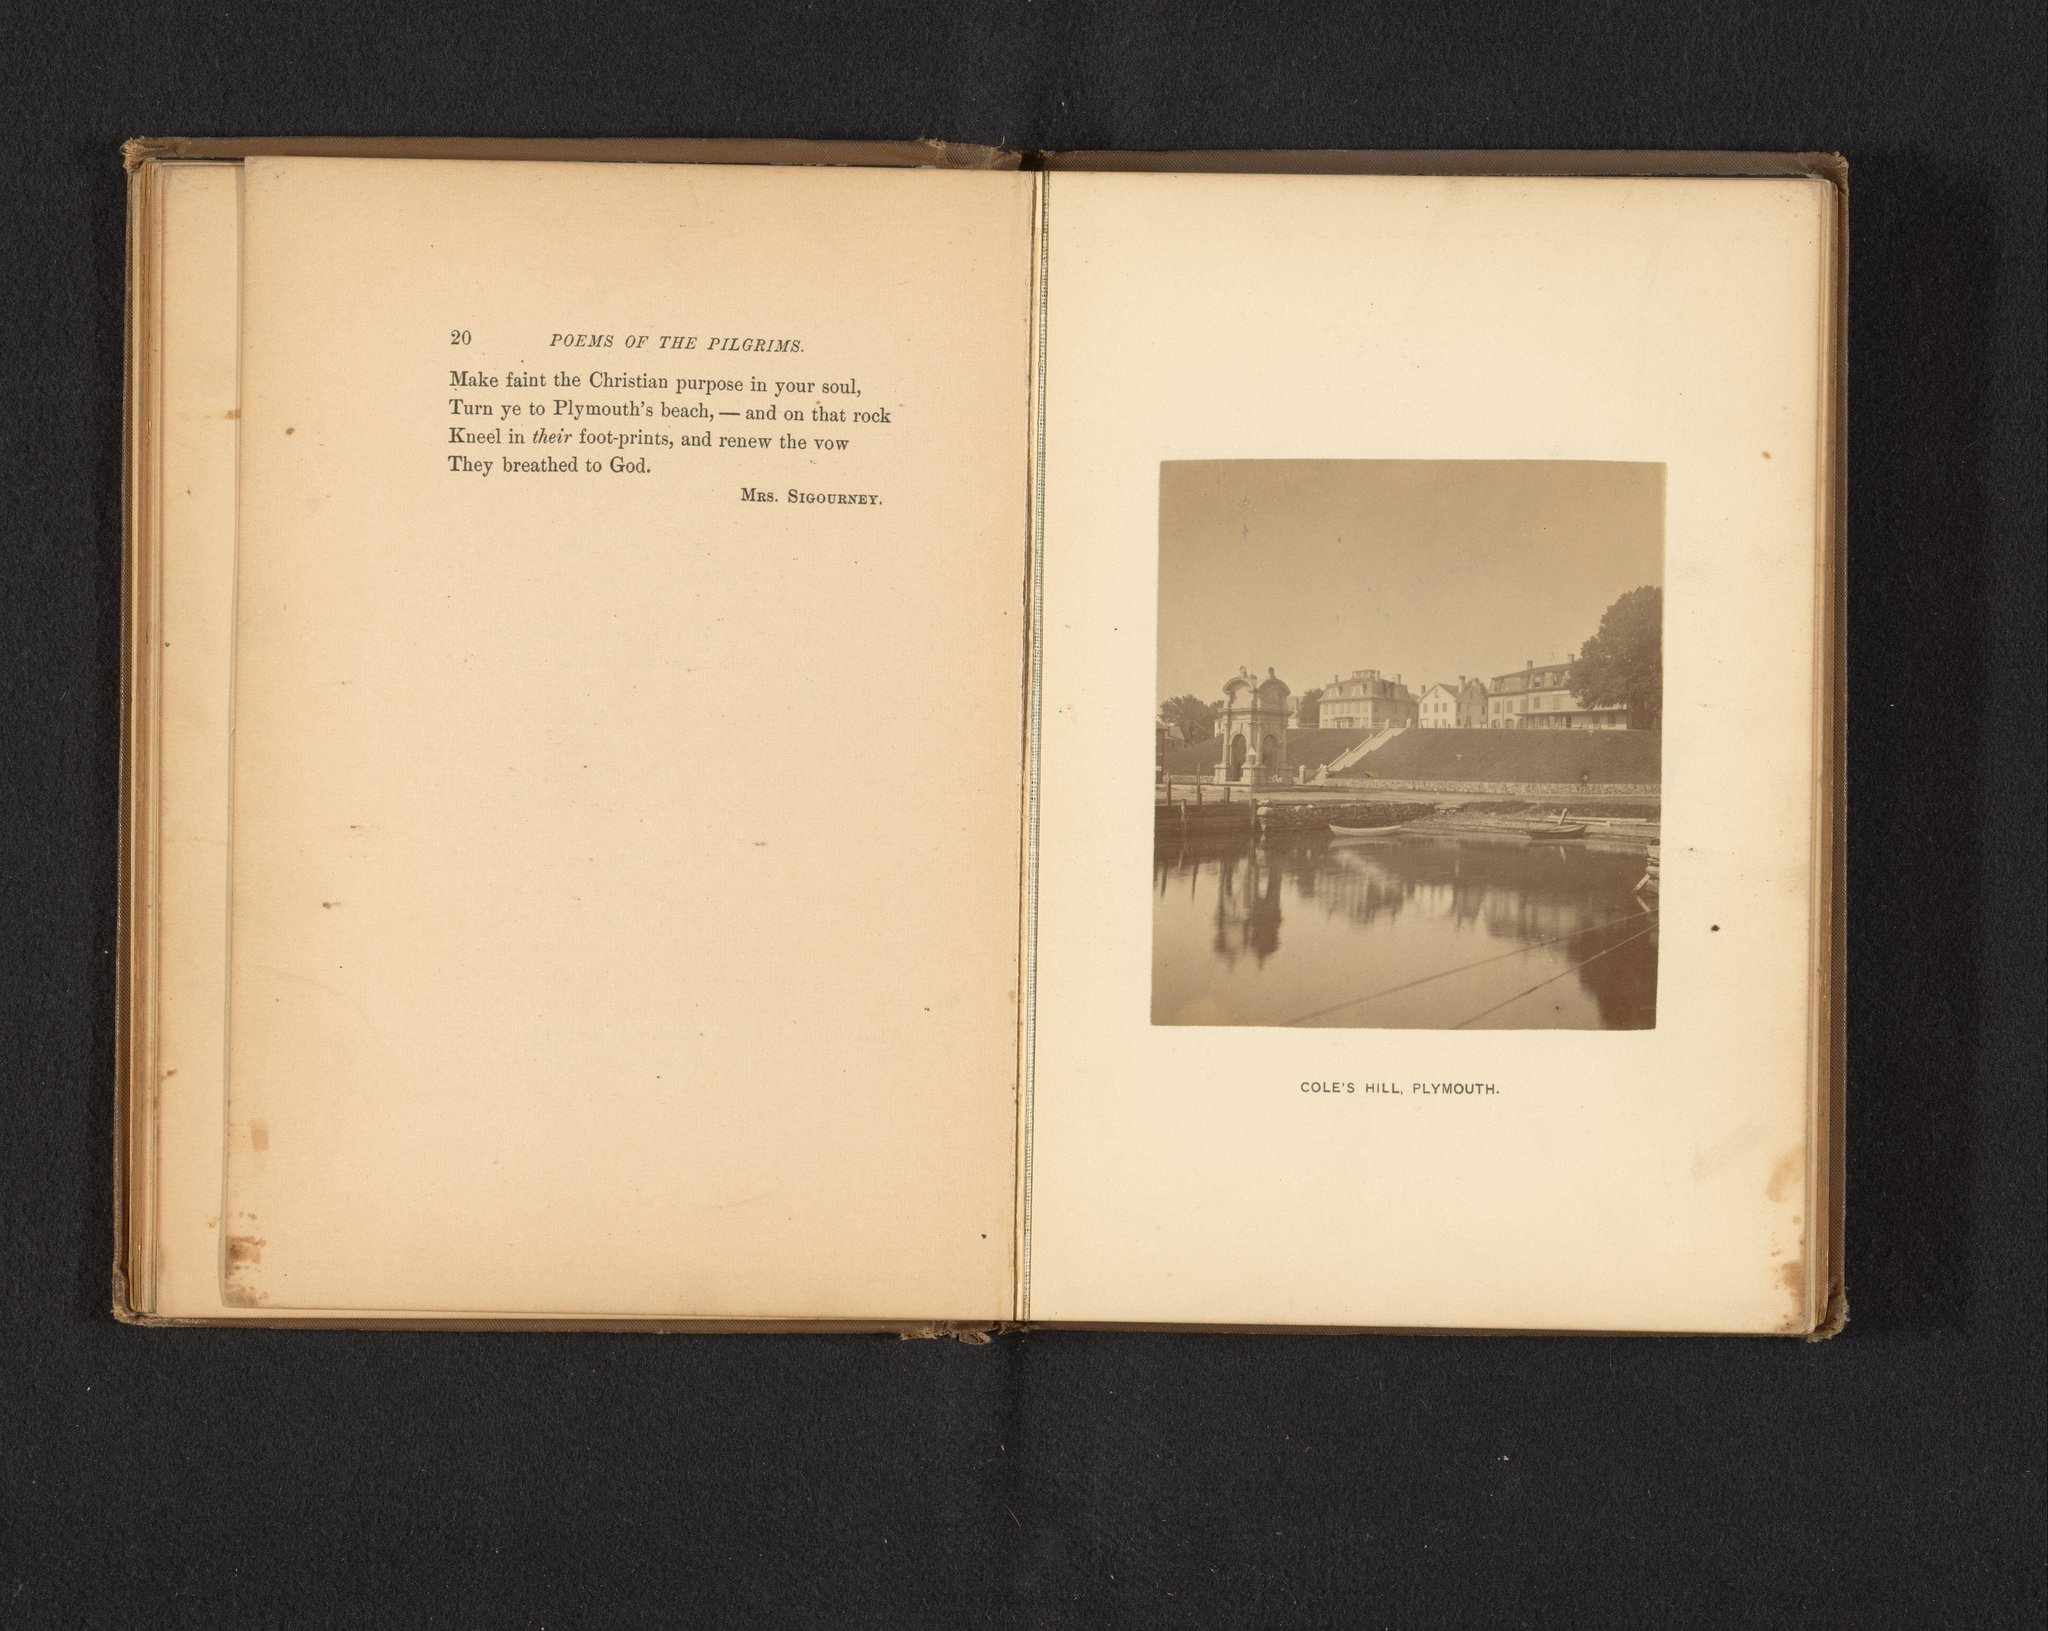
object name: page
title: Cole's Hill, Plymouth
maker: Anonymous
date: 1881-1886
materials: photographic support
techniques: albumen print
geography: plymouth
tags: canopy, baldachin, churchyard, cemetery